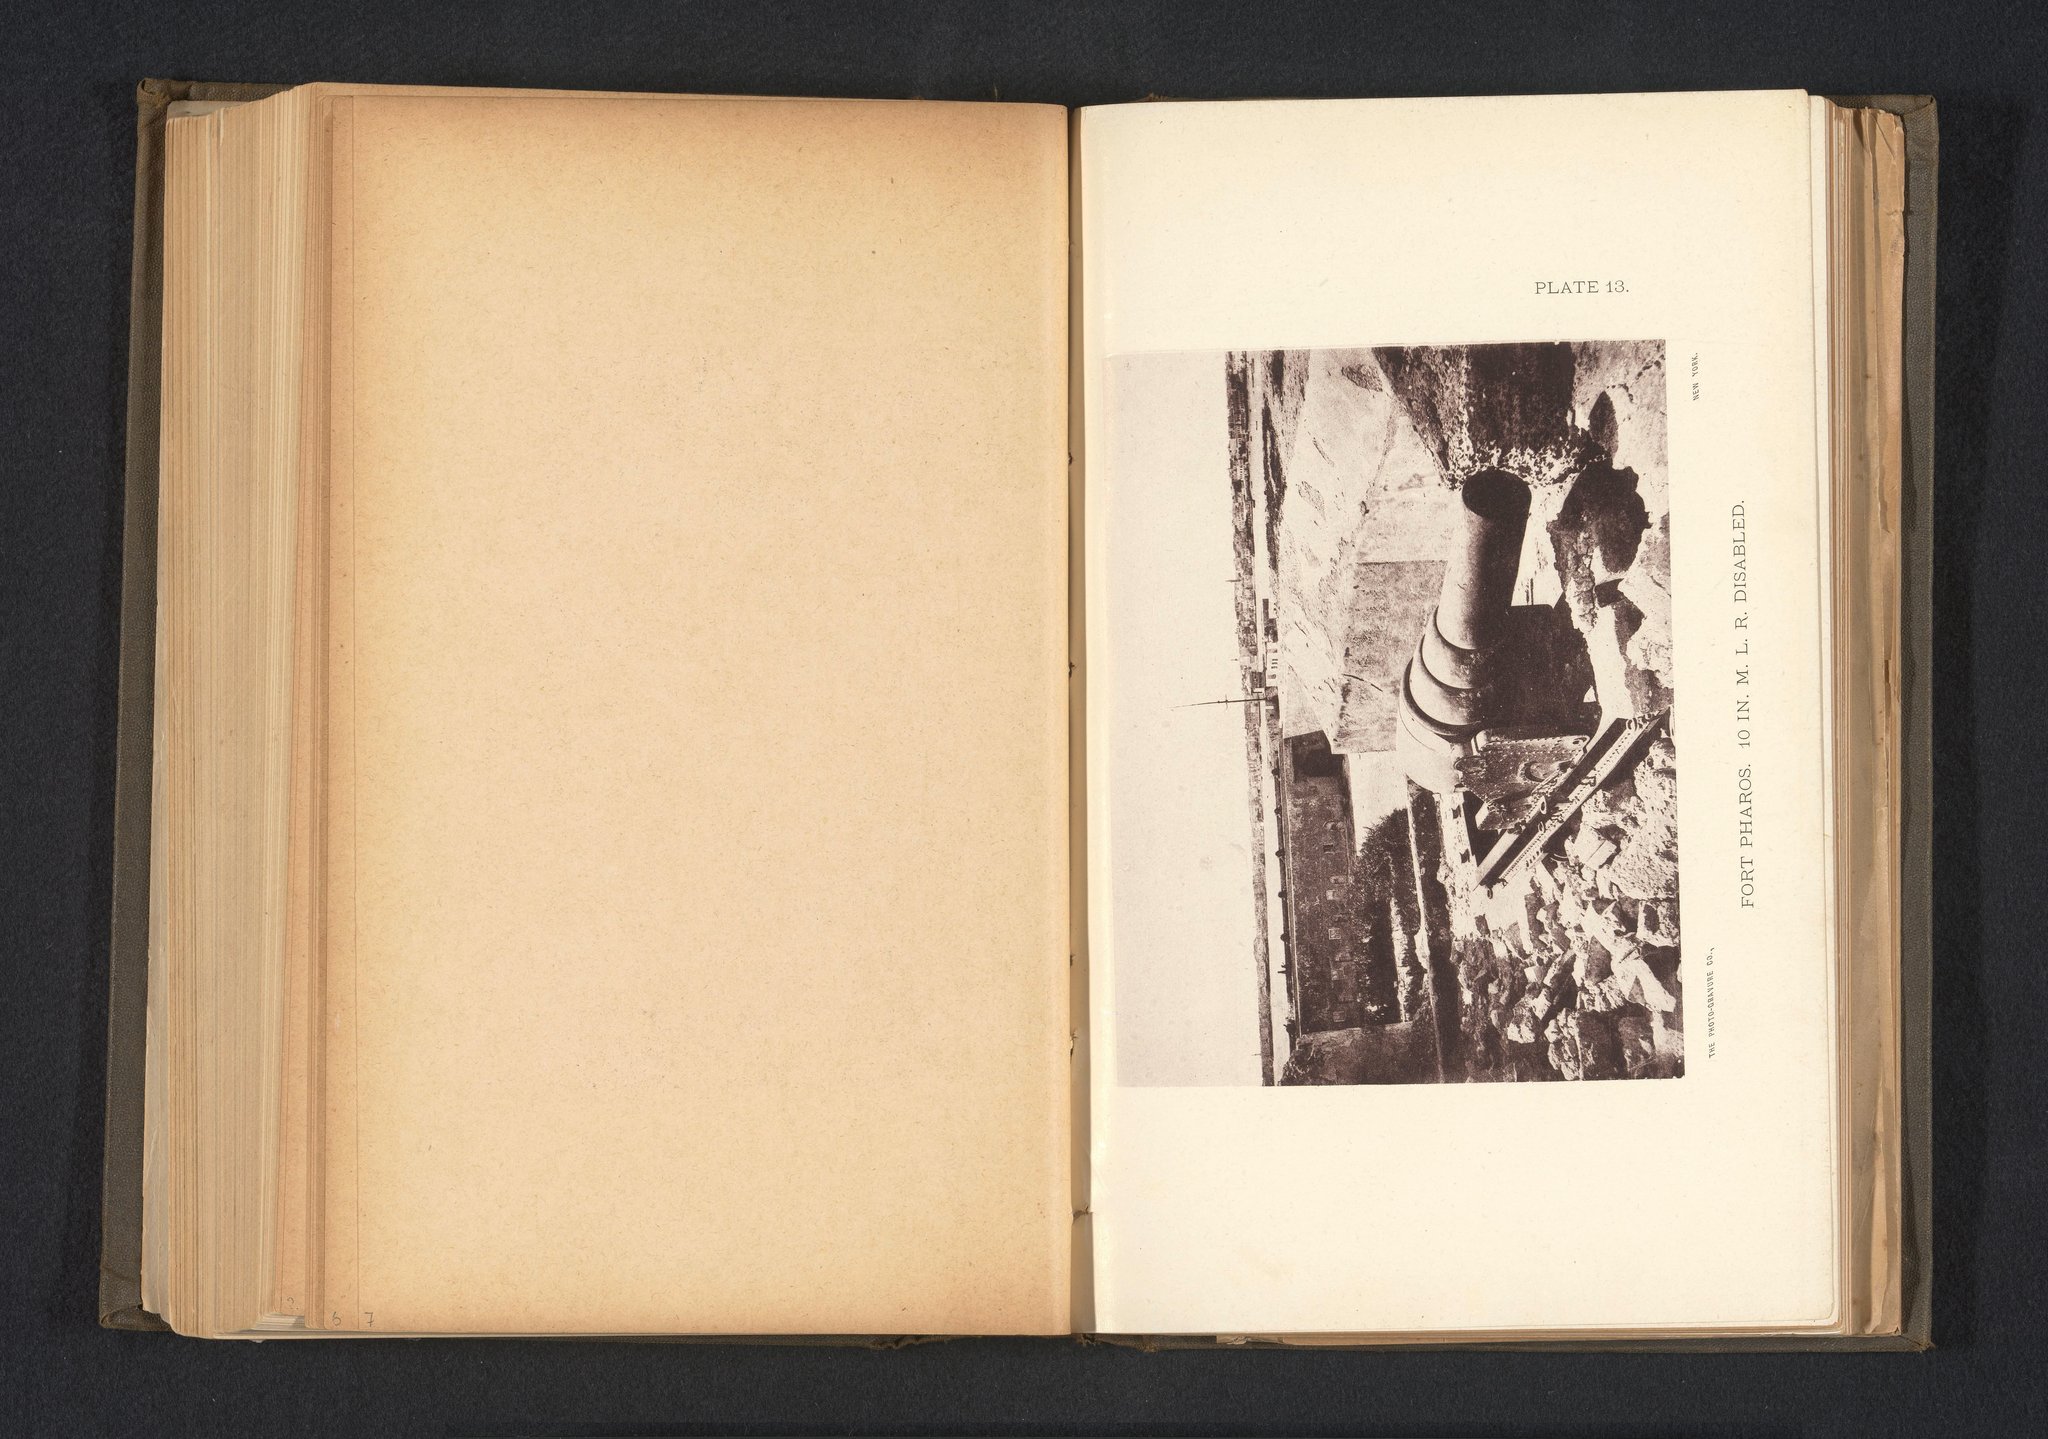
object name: page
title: Fort Pharos. 10 in. m.l.r. disabled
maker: Anonymous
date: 1882-1885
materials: paper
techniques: photograph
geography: new york city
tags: fortress, firearms: cannon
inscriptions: number: ‘Plate 13.’